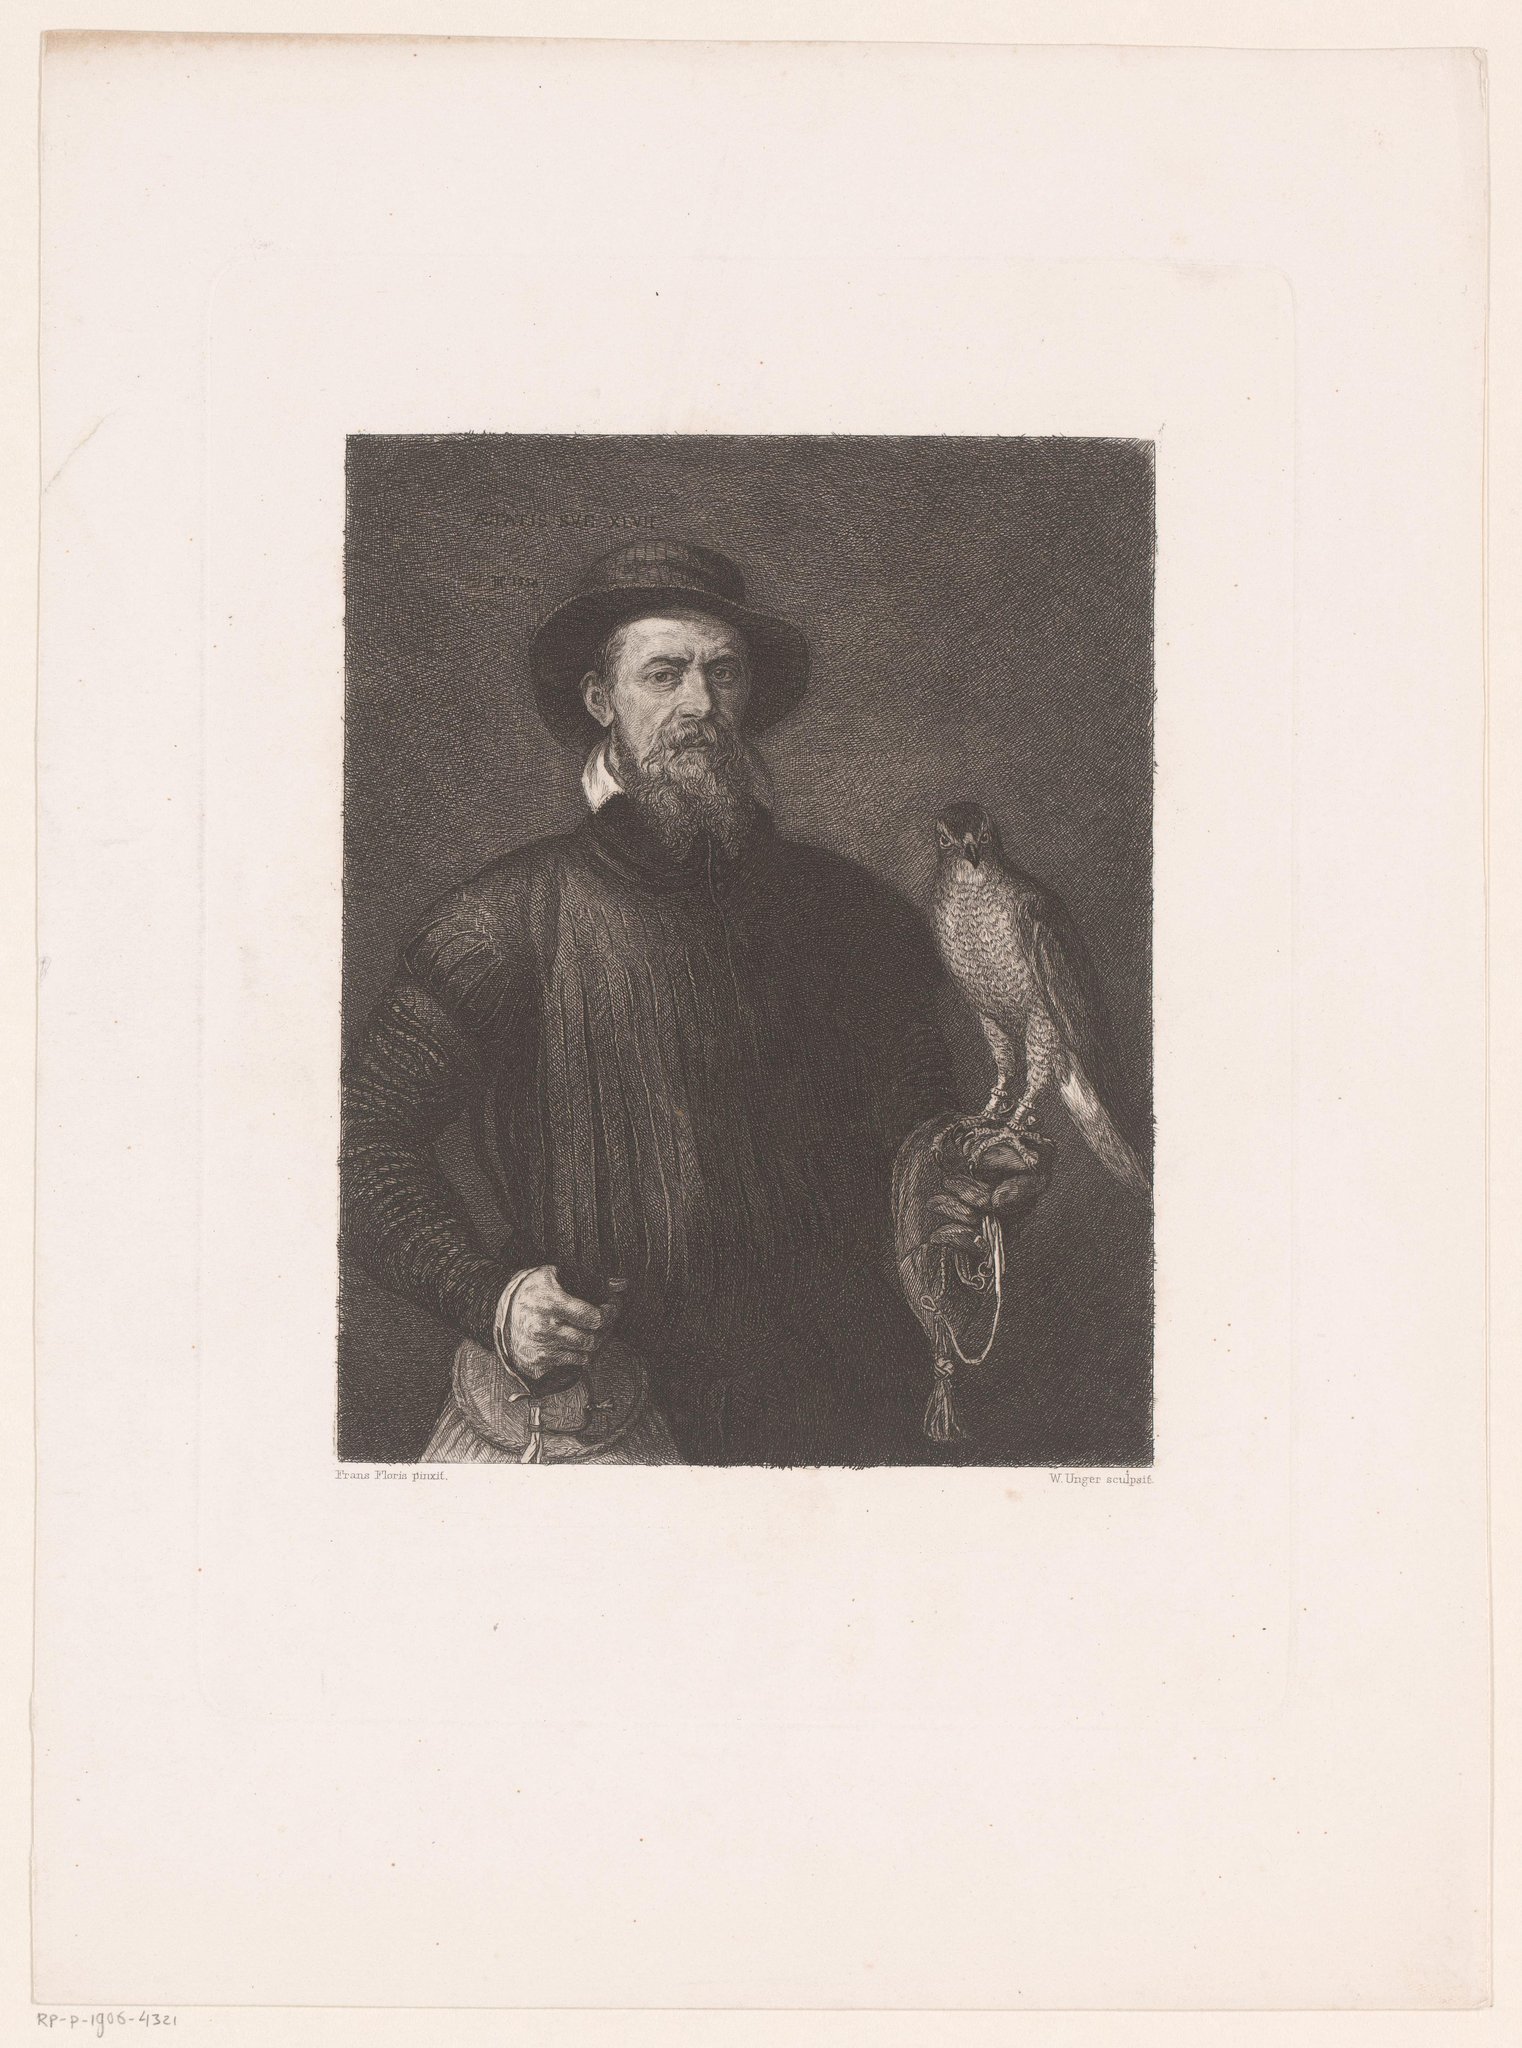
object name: print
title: Portret van een onbekende man met een valk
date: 1847-1889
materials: paper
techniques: etching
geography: germany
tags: predatory birds: falcon, bird hunting, game bag, anonymous historical person portrayed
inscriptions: collector's mark: Lugt 2228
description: Prent naar het schilderij door Frans Floris I in het Herzog Anton Ulrich-Museum Braunschweig (inv.nr. GK 39).